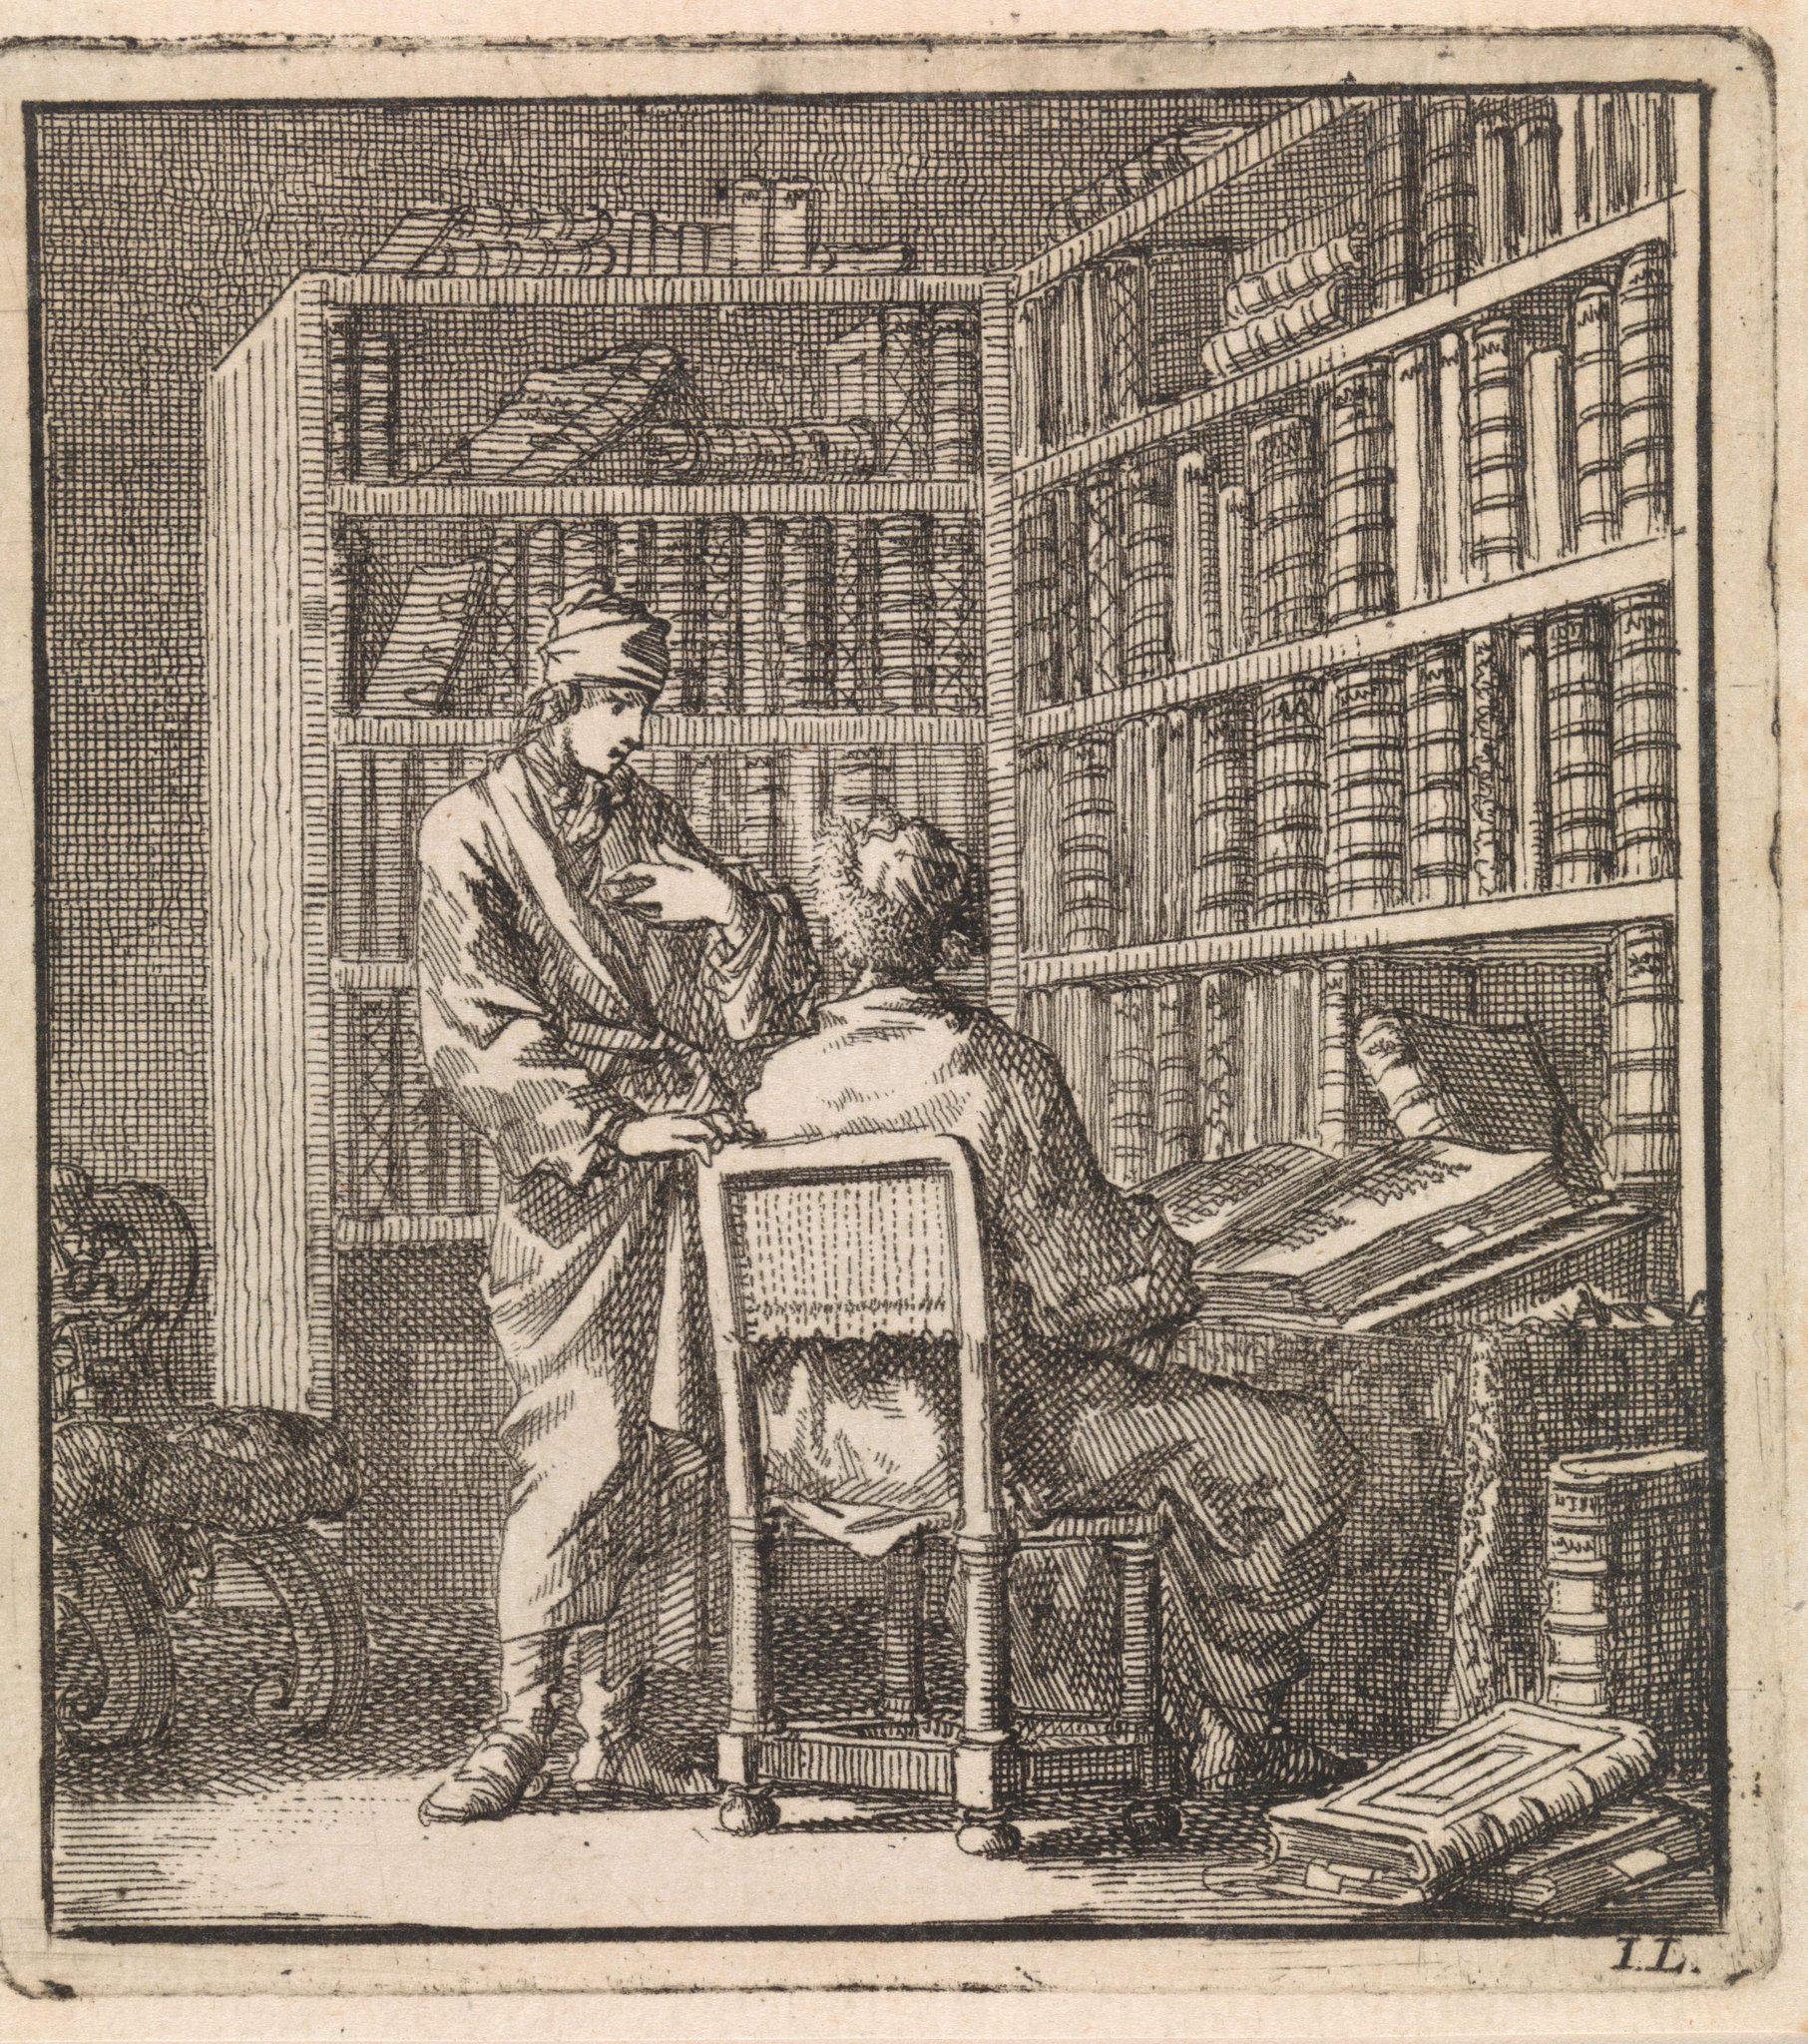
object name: book illustration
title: De Boeke-kas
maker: jan luyken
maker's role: draughtsman, print maker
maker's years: 1649-1712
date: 1711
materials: paper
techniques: etching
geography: amsterdam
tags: reading, book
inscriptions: collector's mark: Lugt 2228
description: Illustratie voor: Luyken, Jan. Het leerzaam huisraad, vertoond in vyftig konstige figuuren, met godlyke spreuken en stichtelyke verzen: Pieter Arentsz. II (wed.) en Cornelis van der Sys, 1711, p. 72.